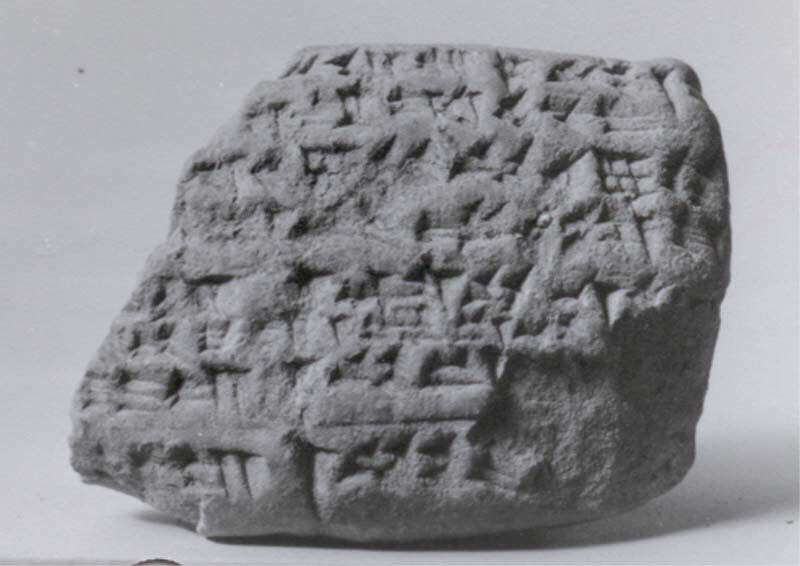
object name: cuneiform tablet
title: Cuneiform tablet: account of esru-tithe payments, Ebabbar archive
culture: babylonian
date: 576 BCE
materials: clay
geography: mesopotamia